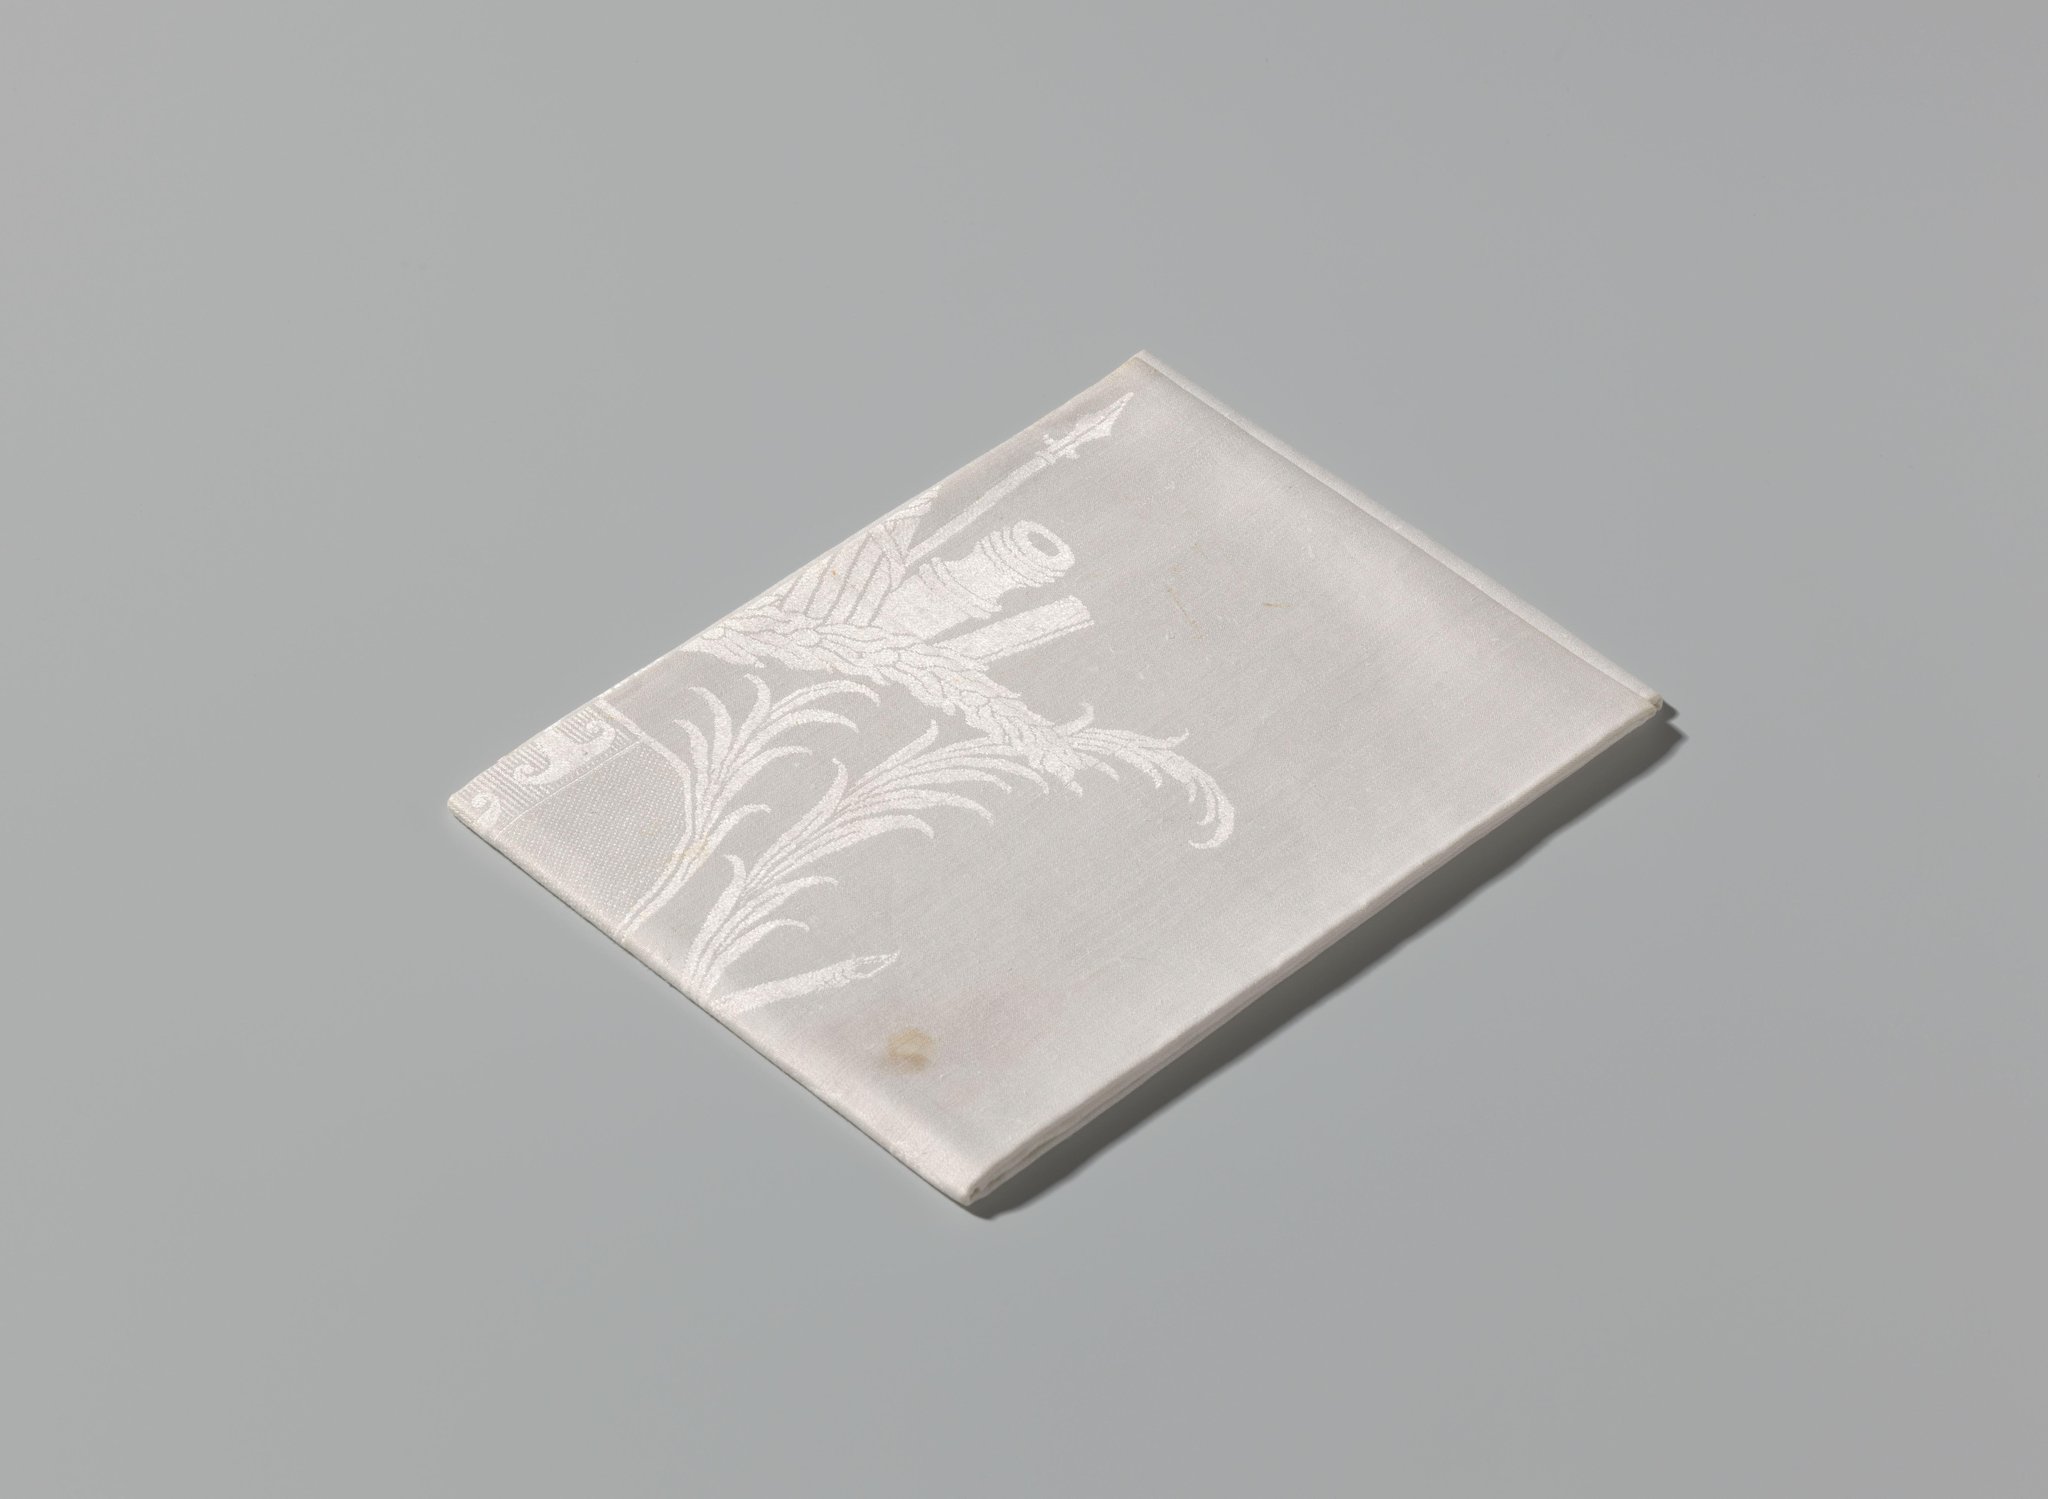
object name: napkin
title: Servet met het wapen van Wijk bij Duurstede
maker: Anonymous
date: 1786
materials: linen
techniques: damask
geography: north brabant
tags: wijk bij duurstede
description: Servet van linnendamast met het wapen van Wijk bij Duurstede, omgeven door lauwertakken en rustend op een trofee met bajonetten, vlaggen, vuurmonden en fascesbundel. Daaronder het opschrift 20 MAART 1786 en daaronder DAN 30. De rand heeft een slingerende tak met eikebladeren en eikels. Het servet hoort bij een tafellaken en tien servetten (BK-1955-32-A t/m BK-1955-32-L).